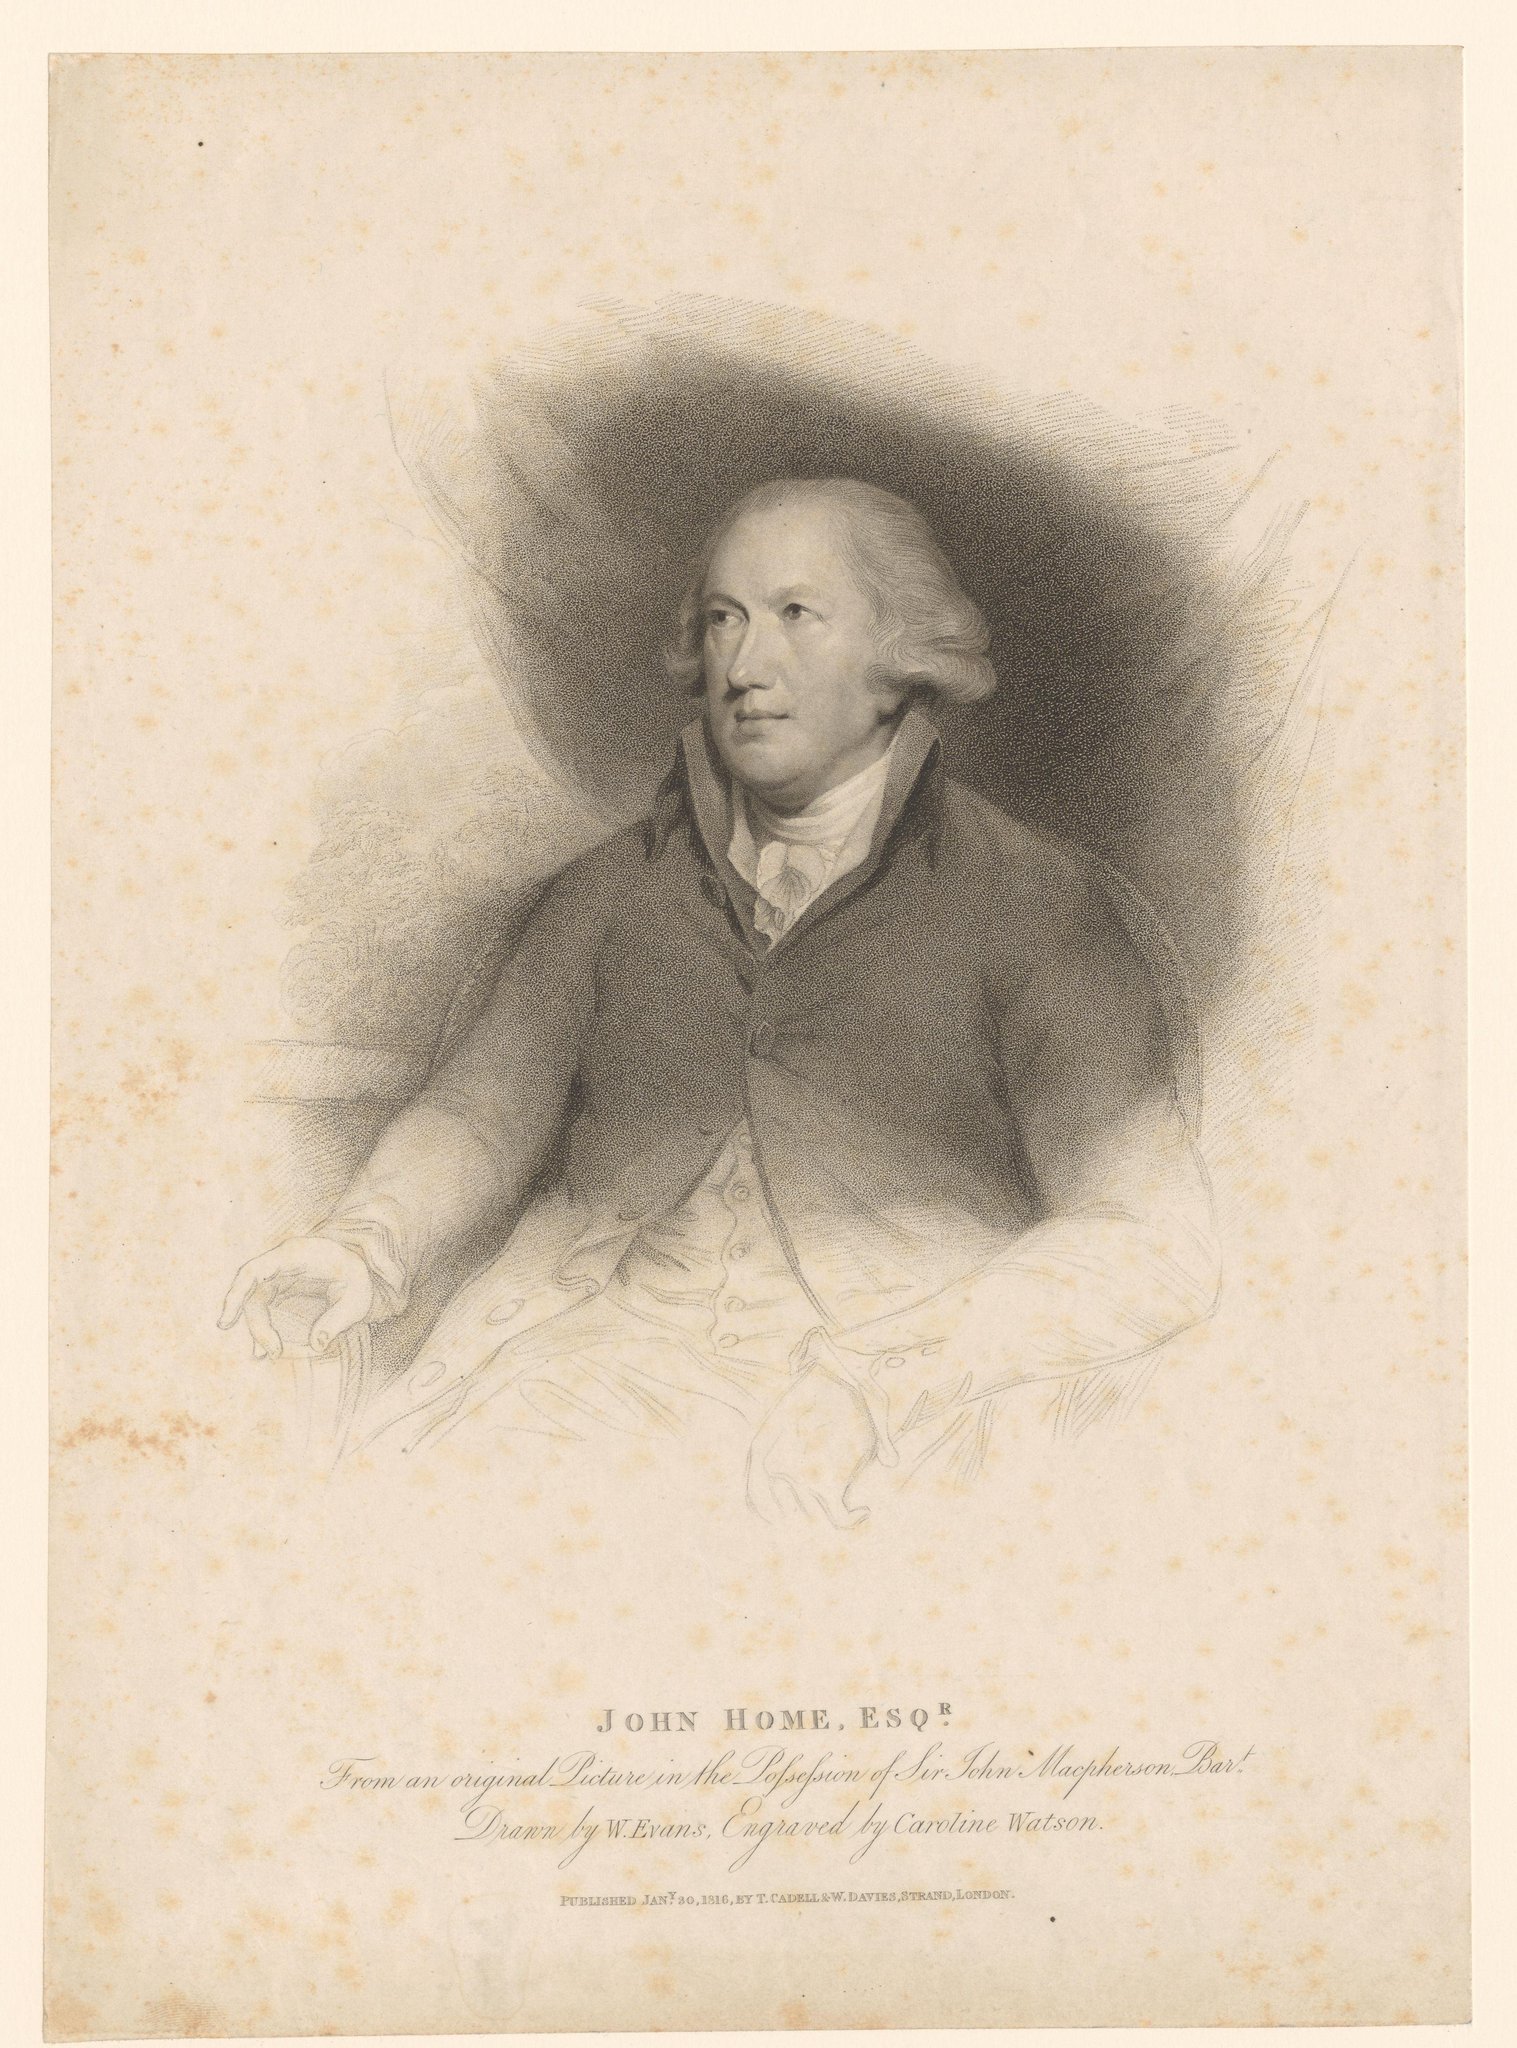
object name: print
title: Portret van John Home Esqr.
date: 1816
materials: paper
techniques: printmaking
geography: london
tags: historical persons, portrait of a writer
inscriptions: collector's mark: Lugt 2228